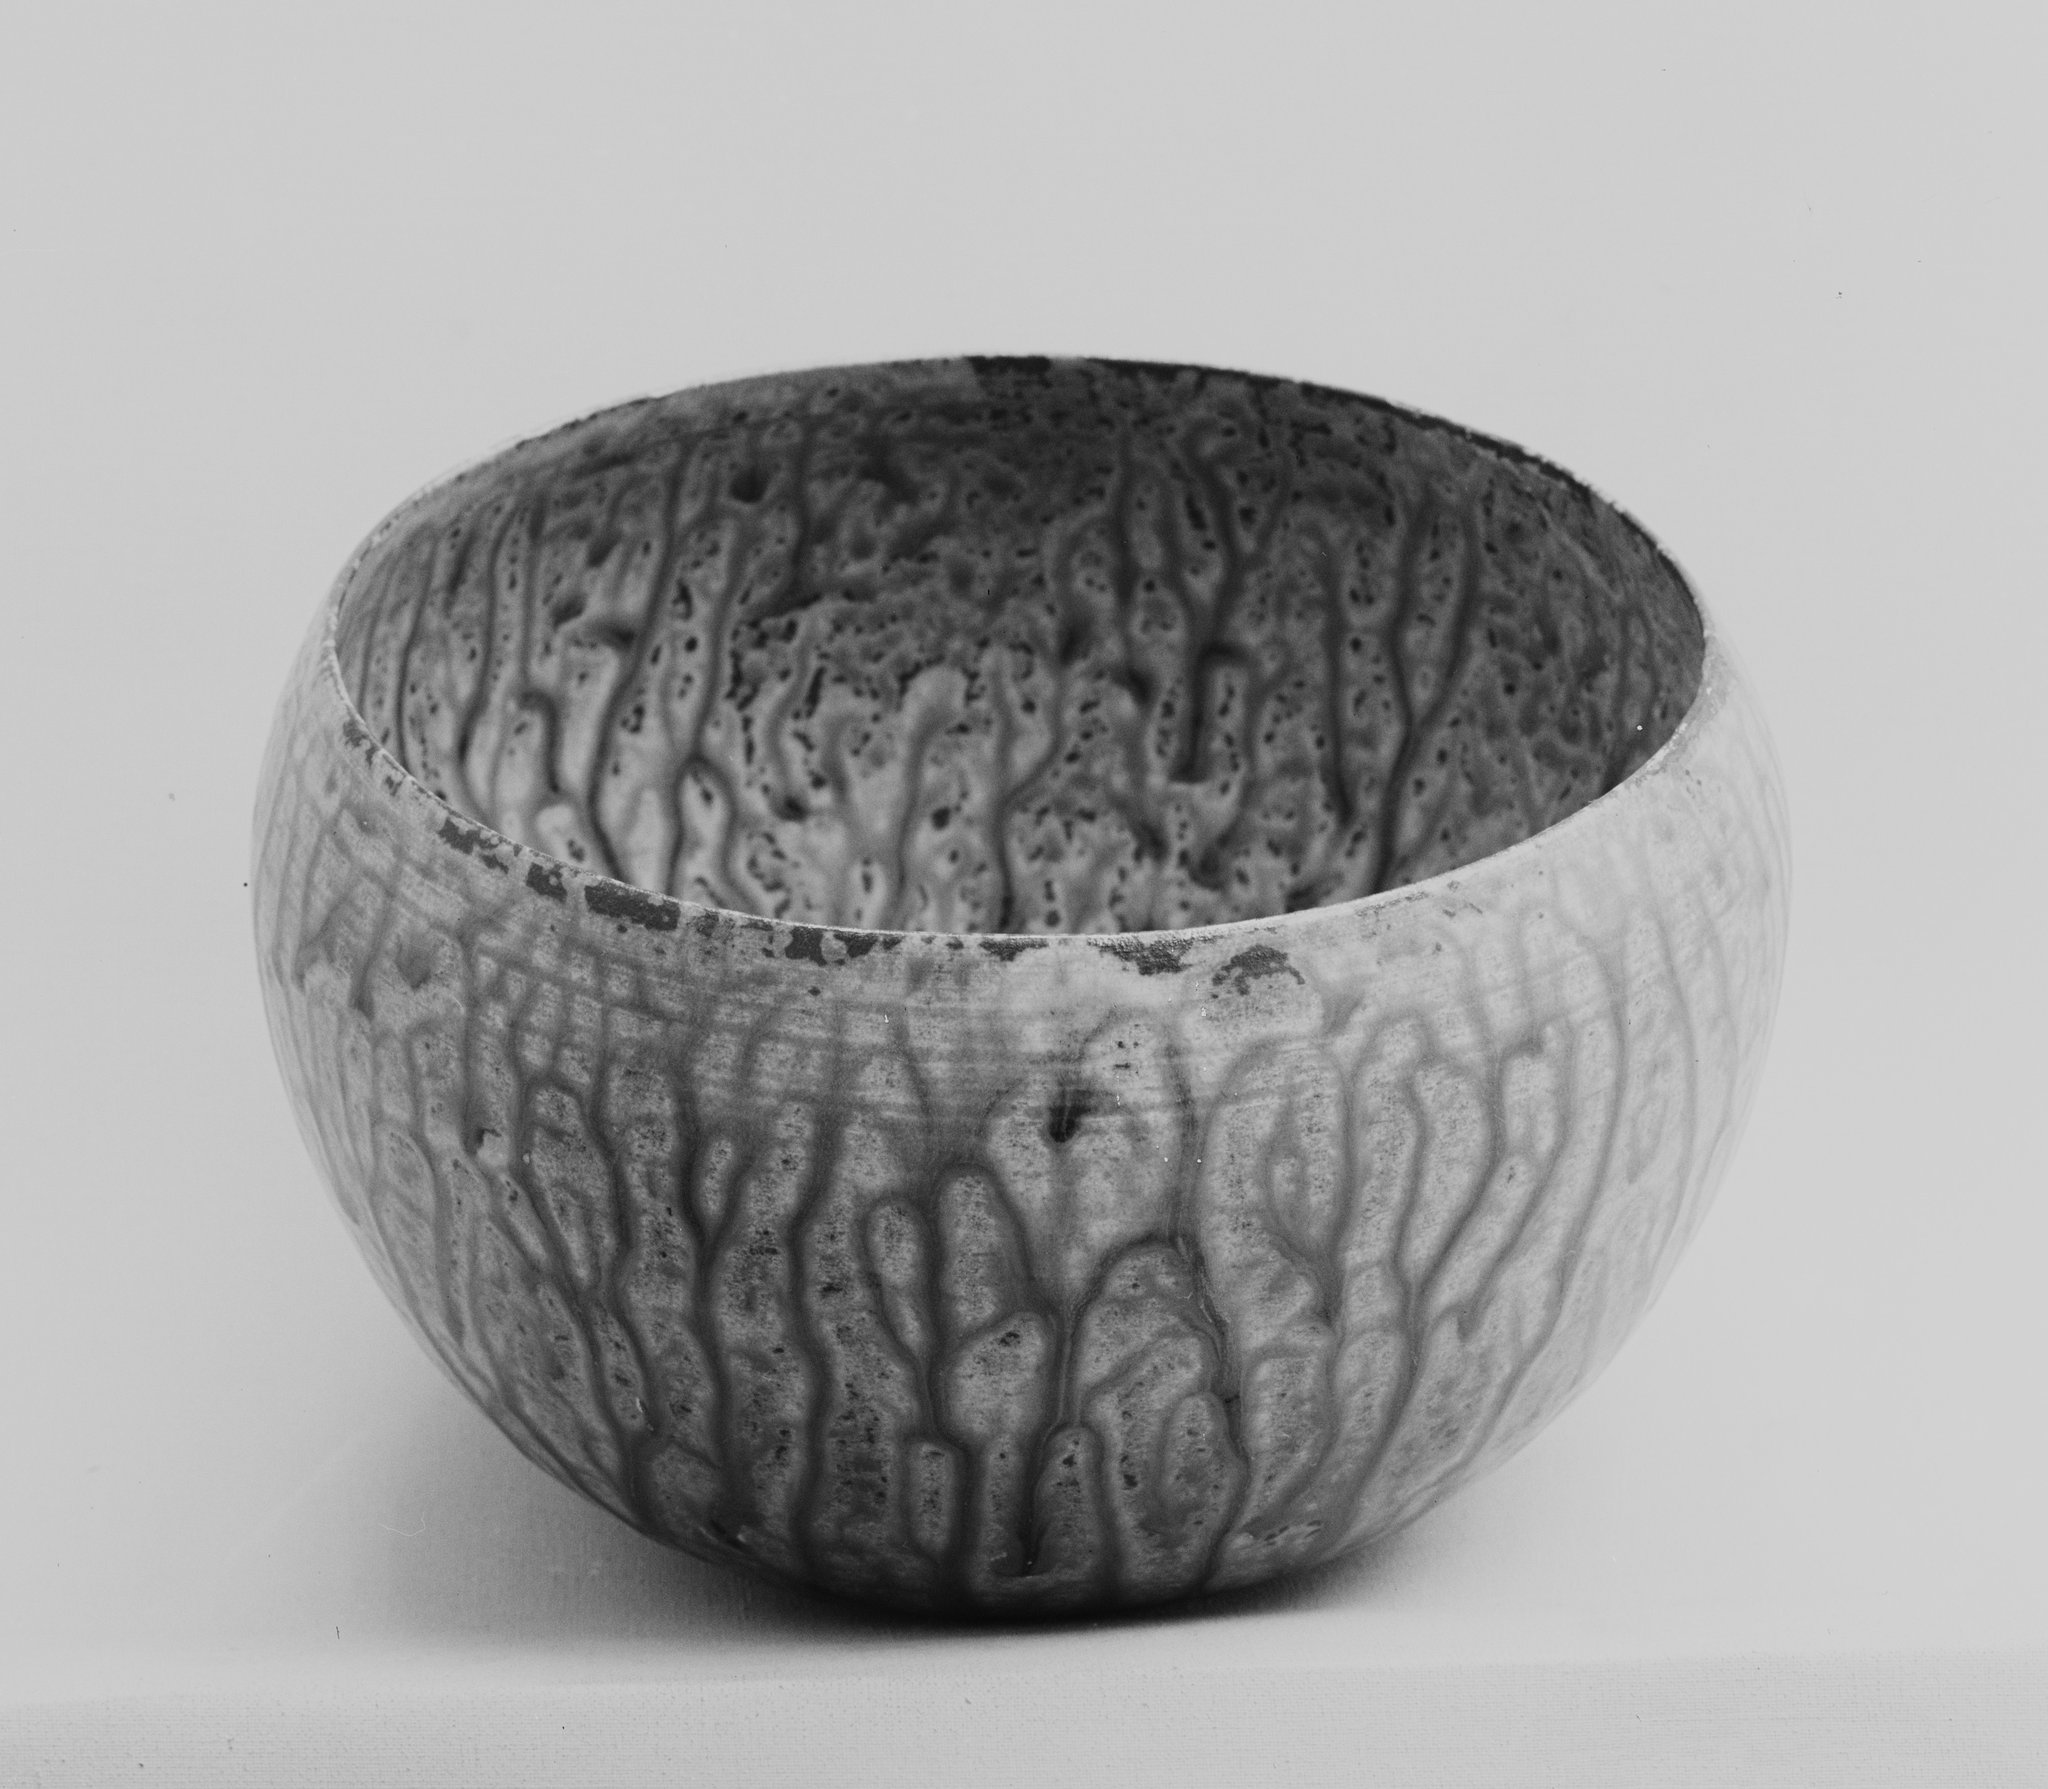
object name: bowl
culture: japanese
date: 1601-1700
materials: clay, glaze